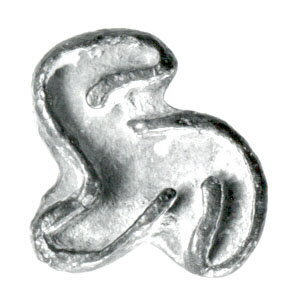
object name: stamp seal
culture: bactria-margiana archaeological complex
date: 2333-1668 BCE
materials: copper alloy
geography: bactria-margiana